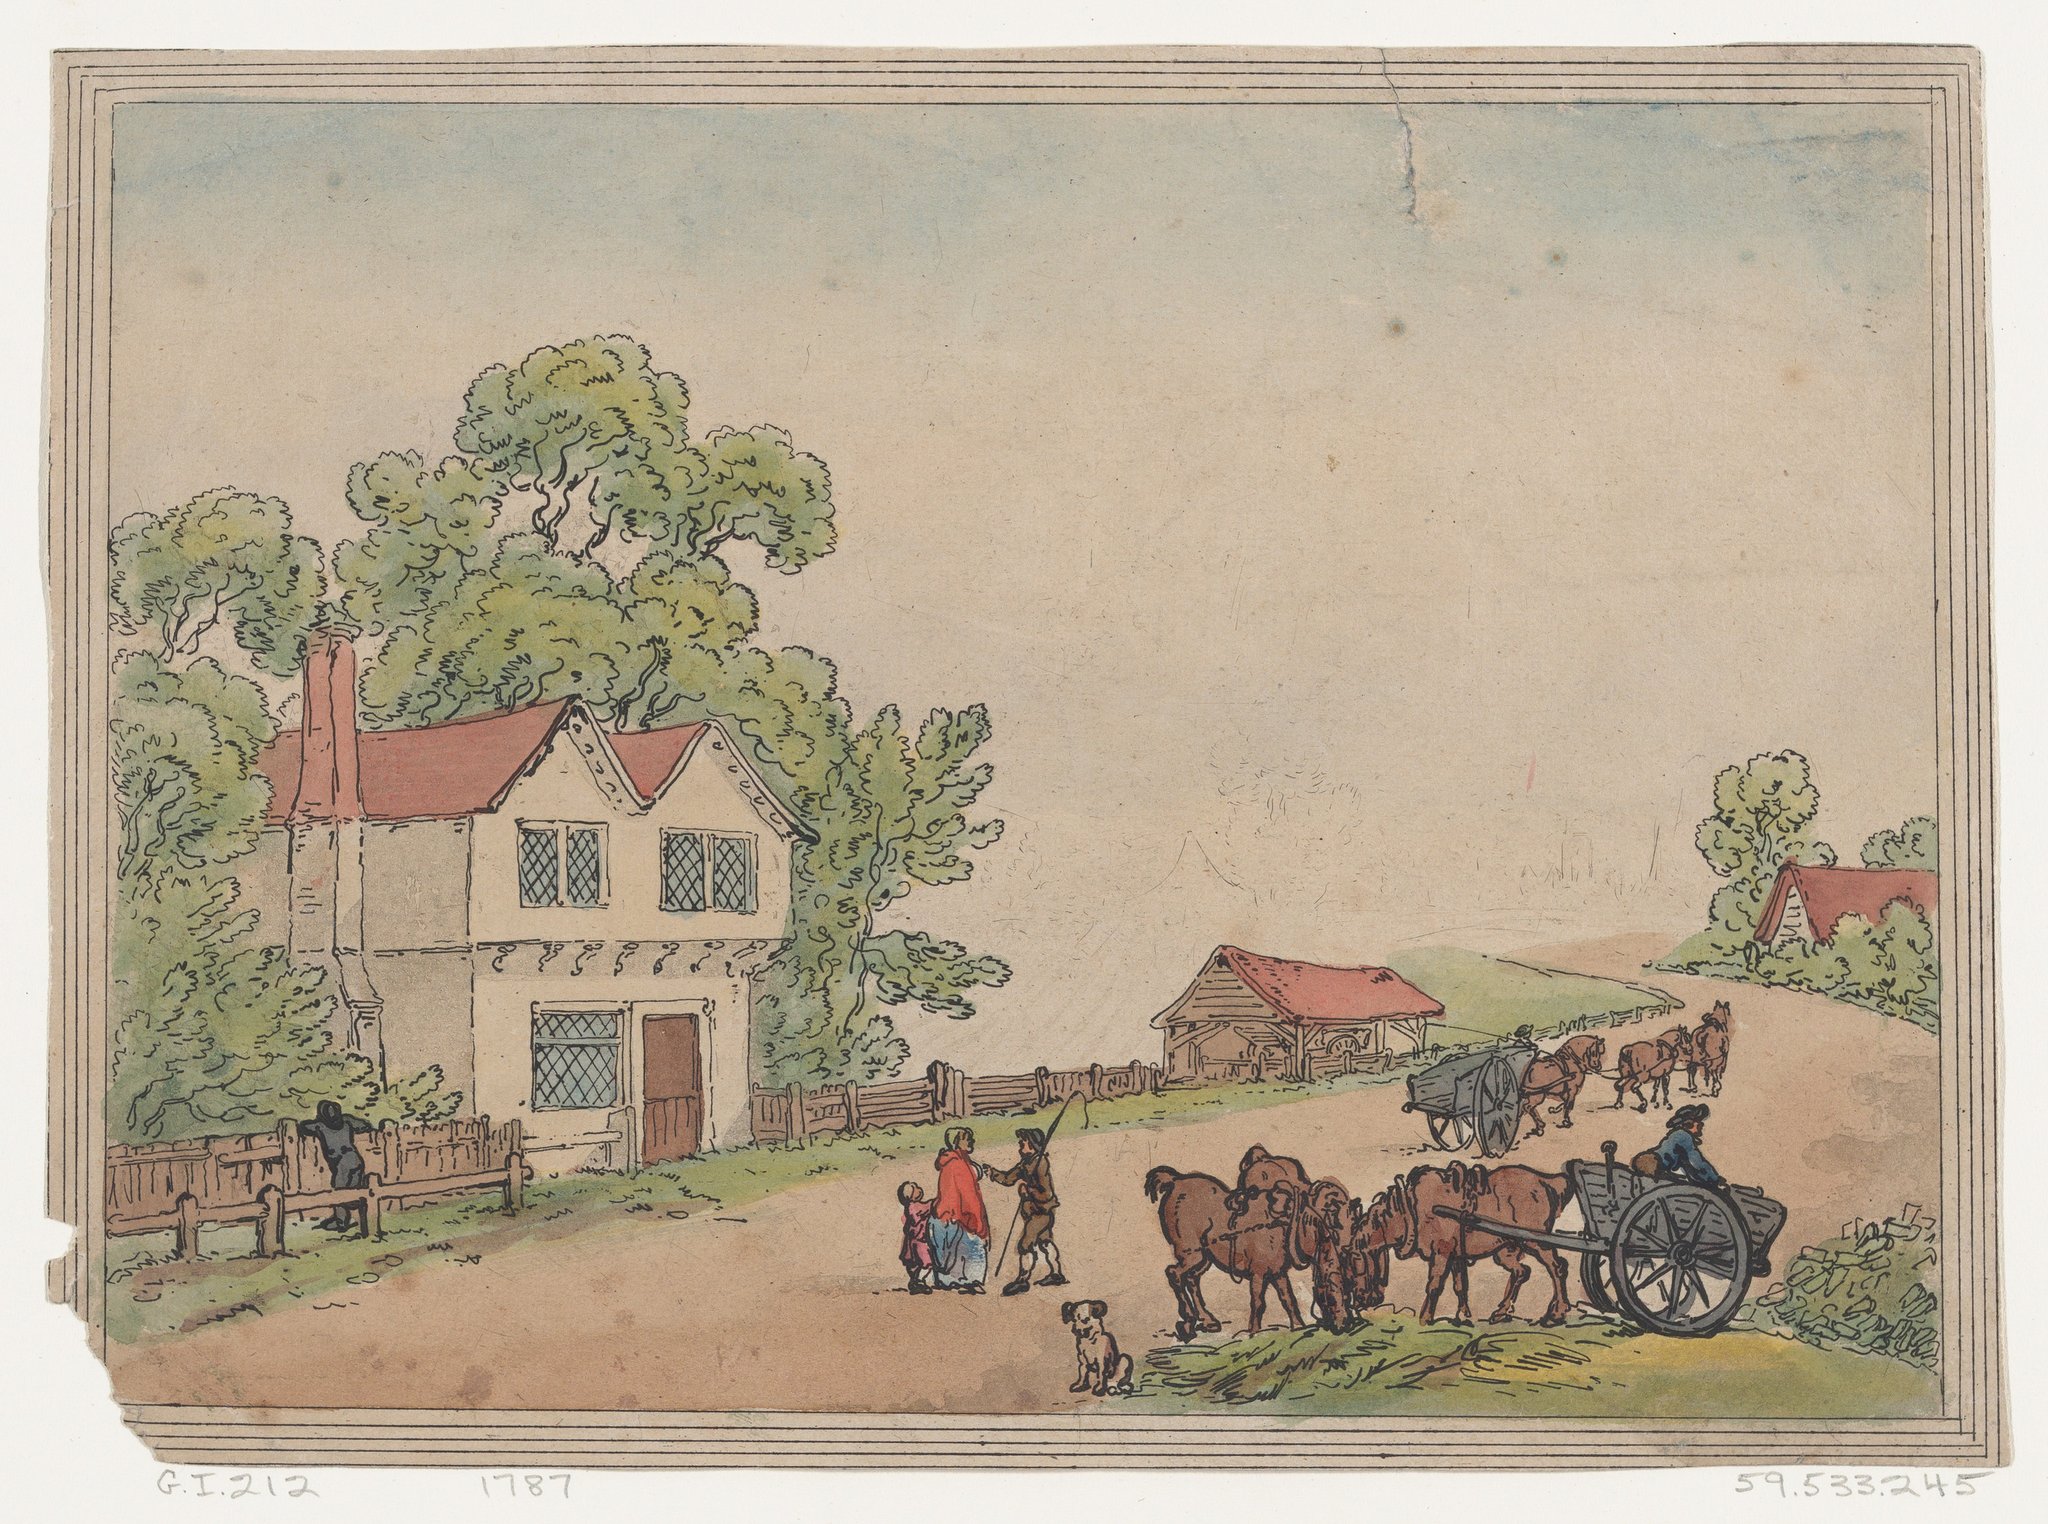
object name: print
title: Rustic Sketch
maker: thomas rowlandson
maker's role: artist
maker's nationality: british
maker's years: 1757-1827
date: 1787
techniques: aquatint, etching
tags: houses,men,dogs,horses,carriages